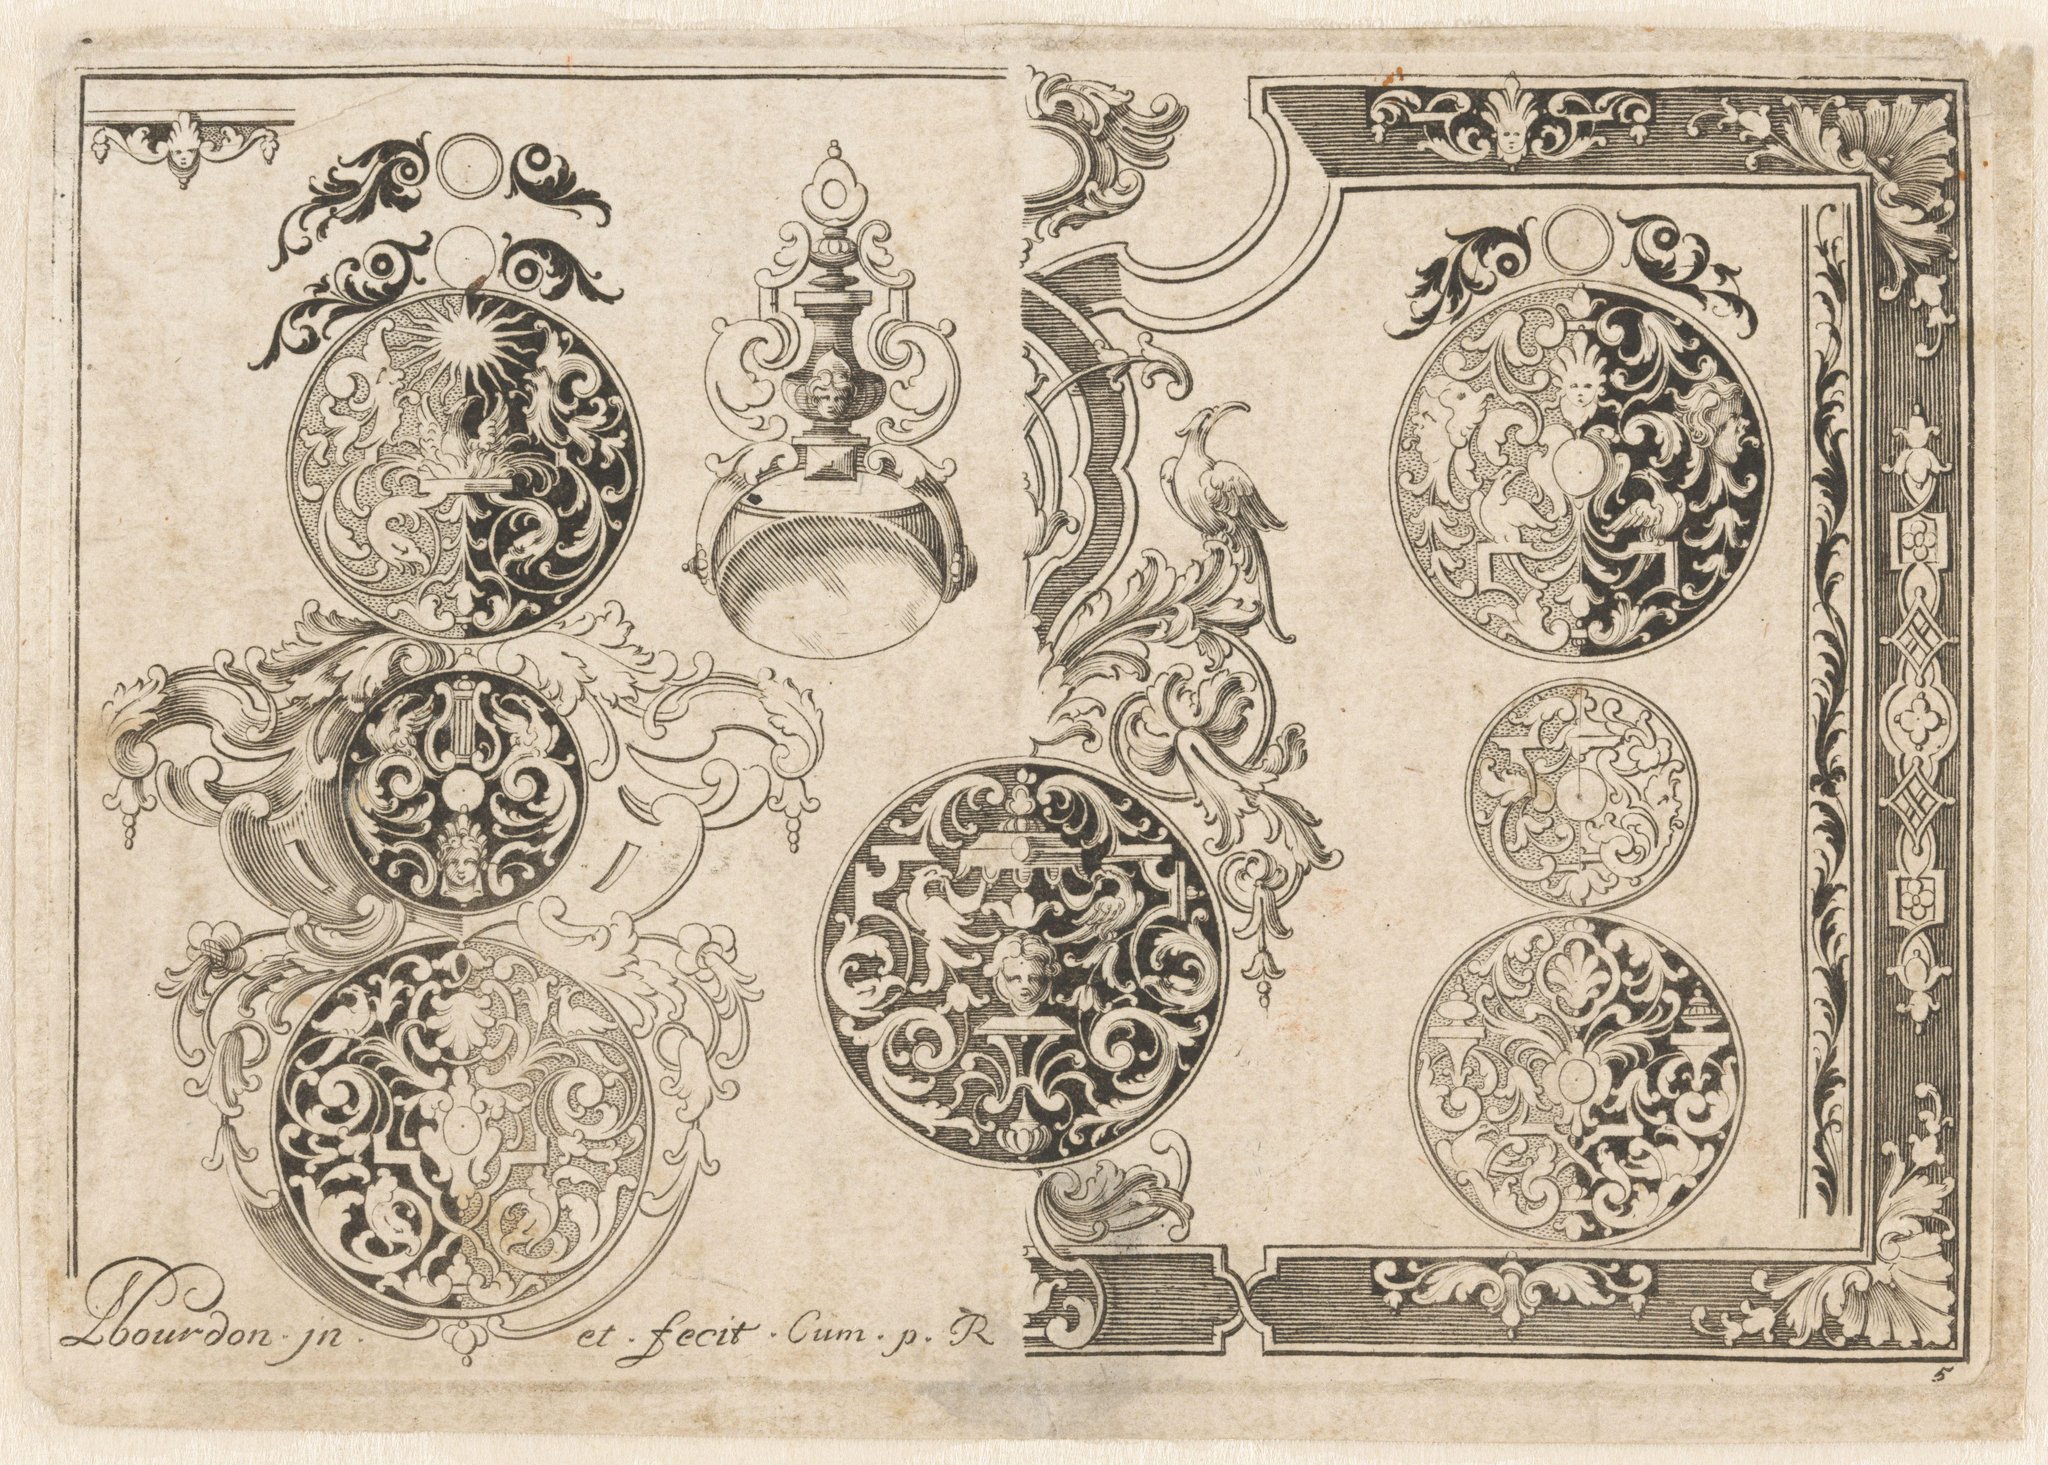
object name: ornament print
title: Livre Premier: Essais de gravure par Pierre Bourdon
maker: pierre bourdon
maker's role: print maker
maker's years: 1656-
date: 1703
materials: paper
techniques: engraving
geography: paris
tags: ornaments ~ art, watch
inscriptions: collector's mark: Lugt 2228, privilege: ‘Cum p. R’, signature: ‘P. bourdon in et fecit’, number: ‘5’, collector's mark: Lugt 2760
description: Blad uit serie van zeven van ontwerpen voor horlogemakers, goudsmeden, beeldhouwers en graveurs.